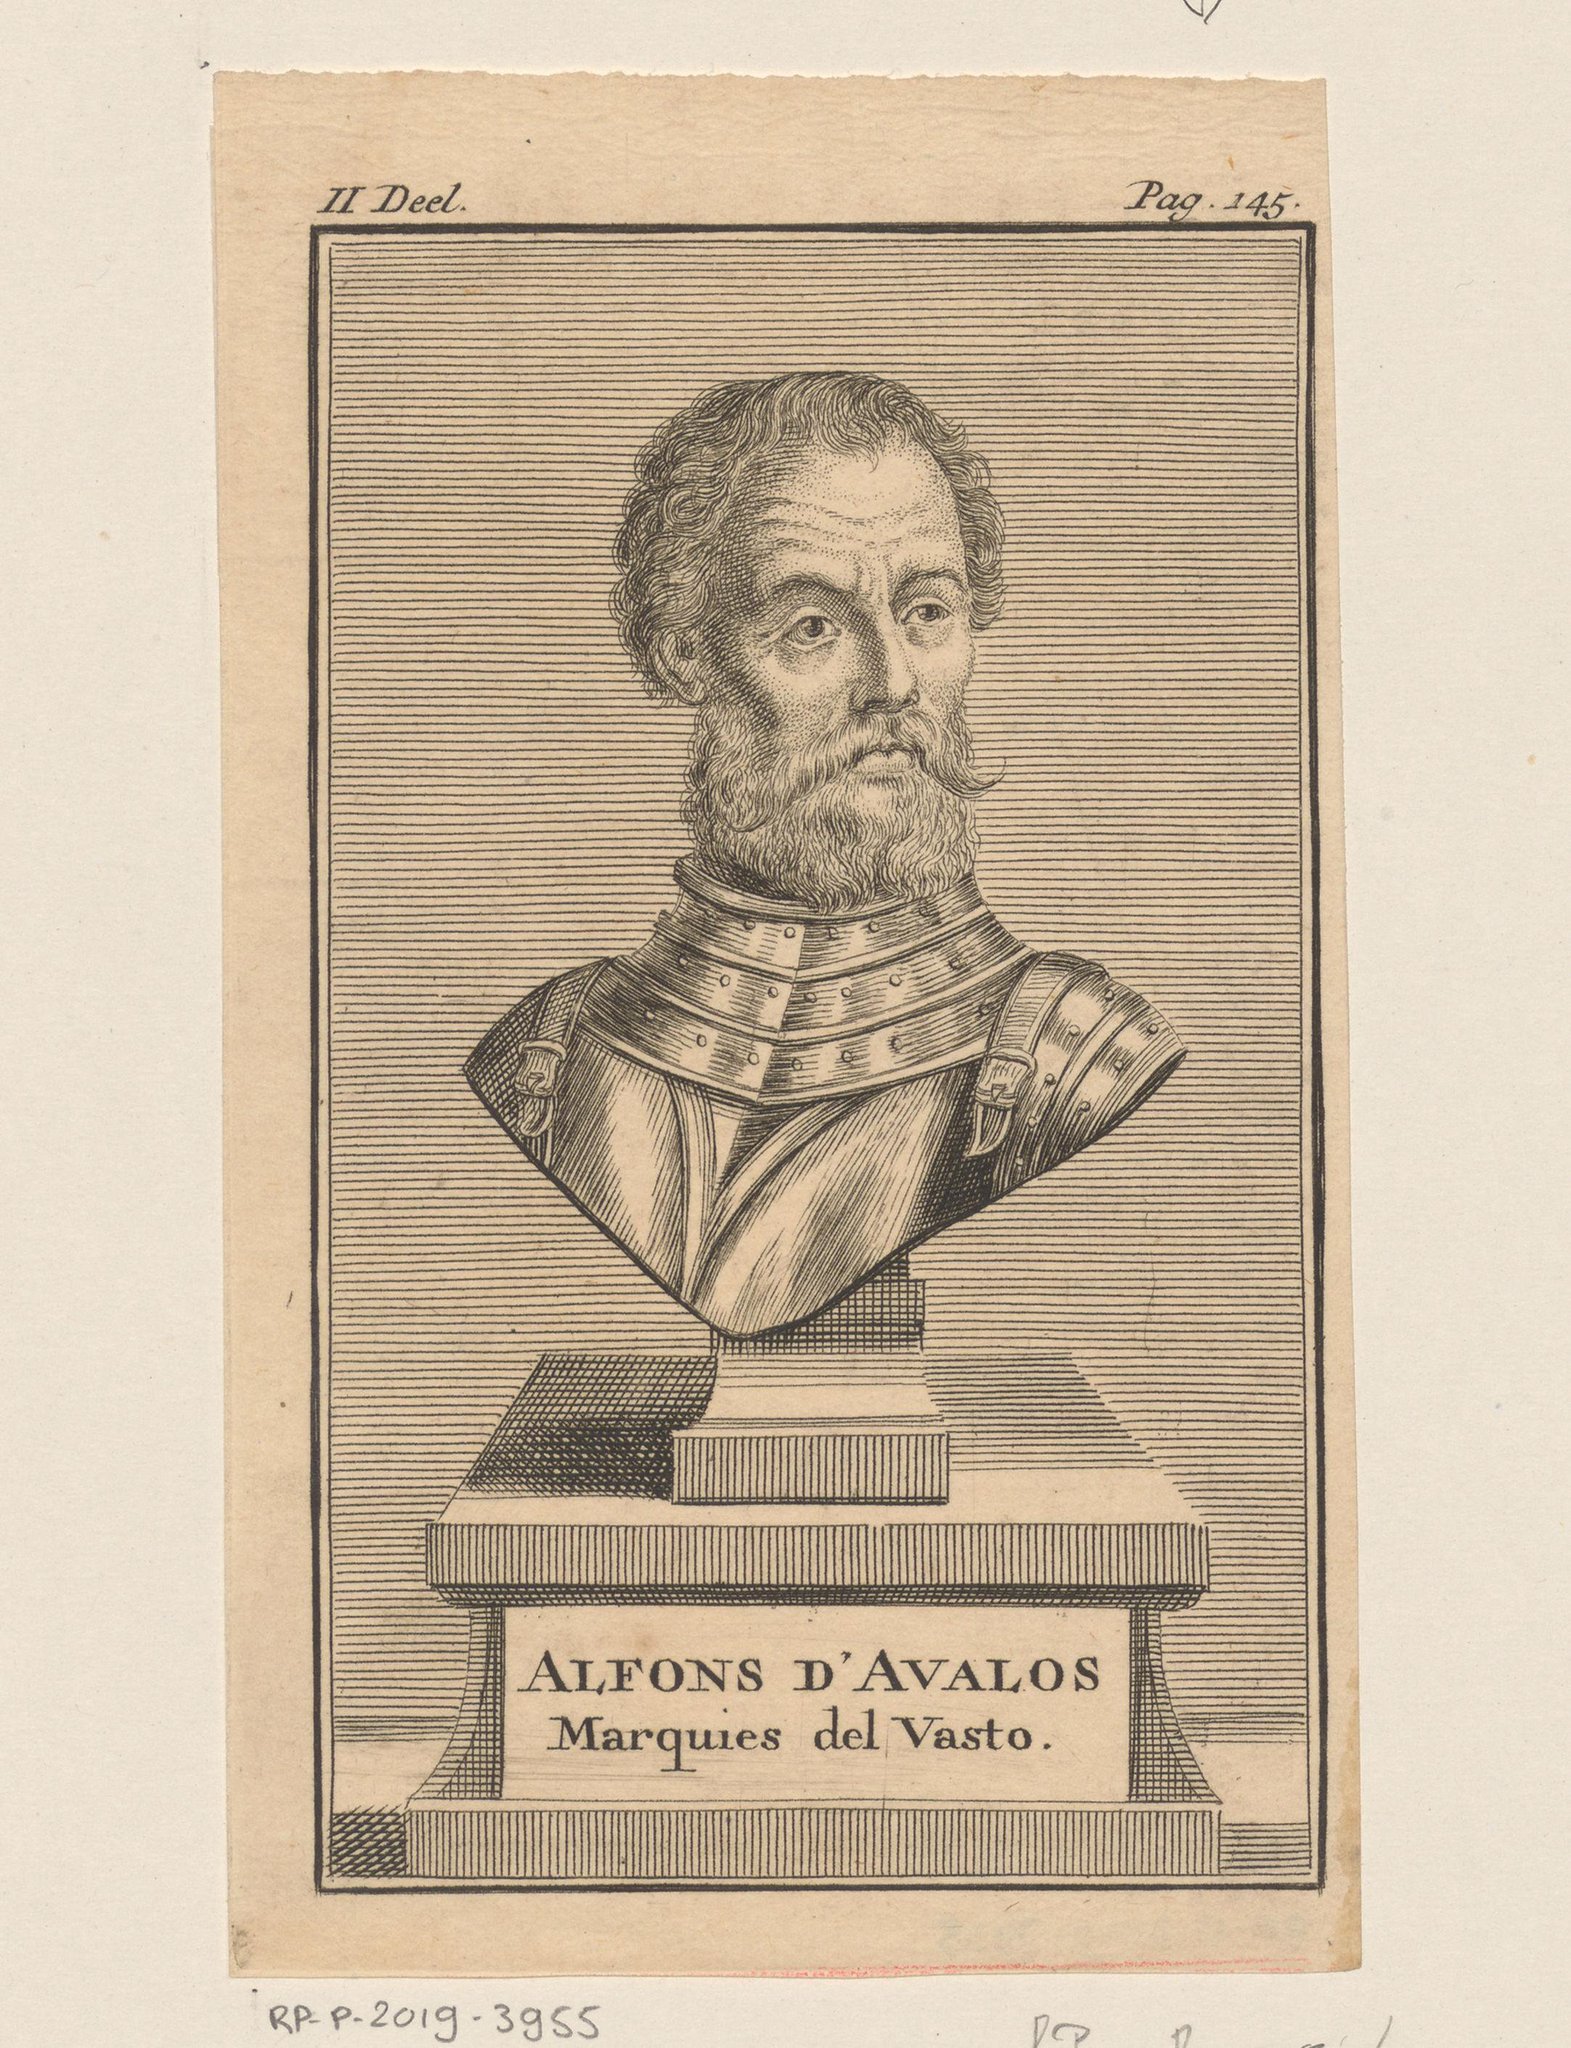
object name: print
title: Portret van Alfonso d'Avalos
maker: Anonymous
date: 1700-1749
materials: paper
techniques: engraving, etching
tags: ischia, isola d', armour, historical persons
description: Links- en rechtsboven genummerd: II Deel. Pag. 145.